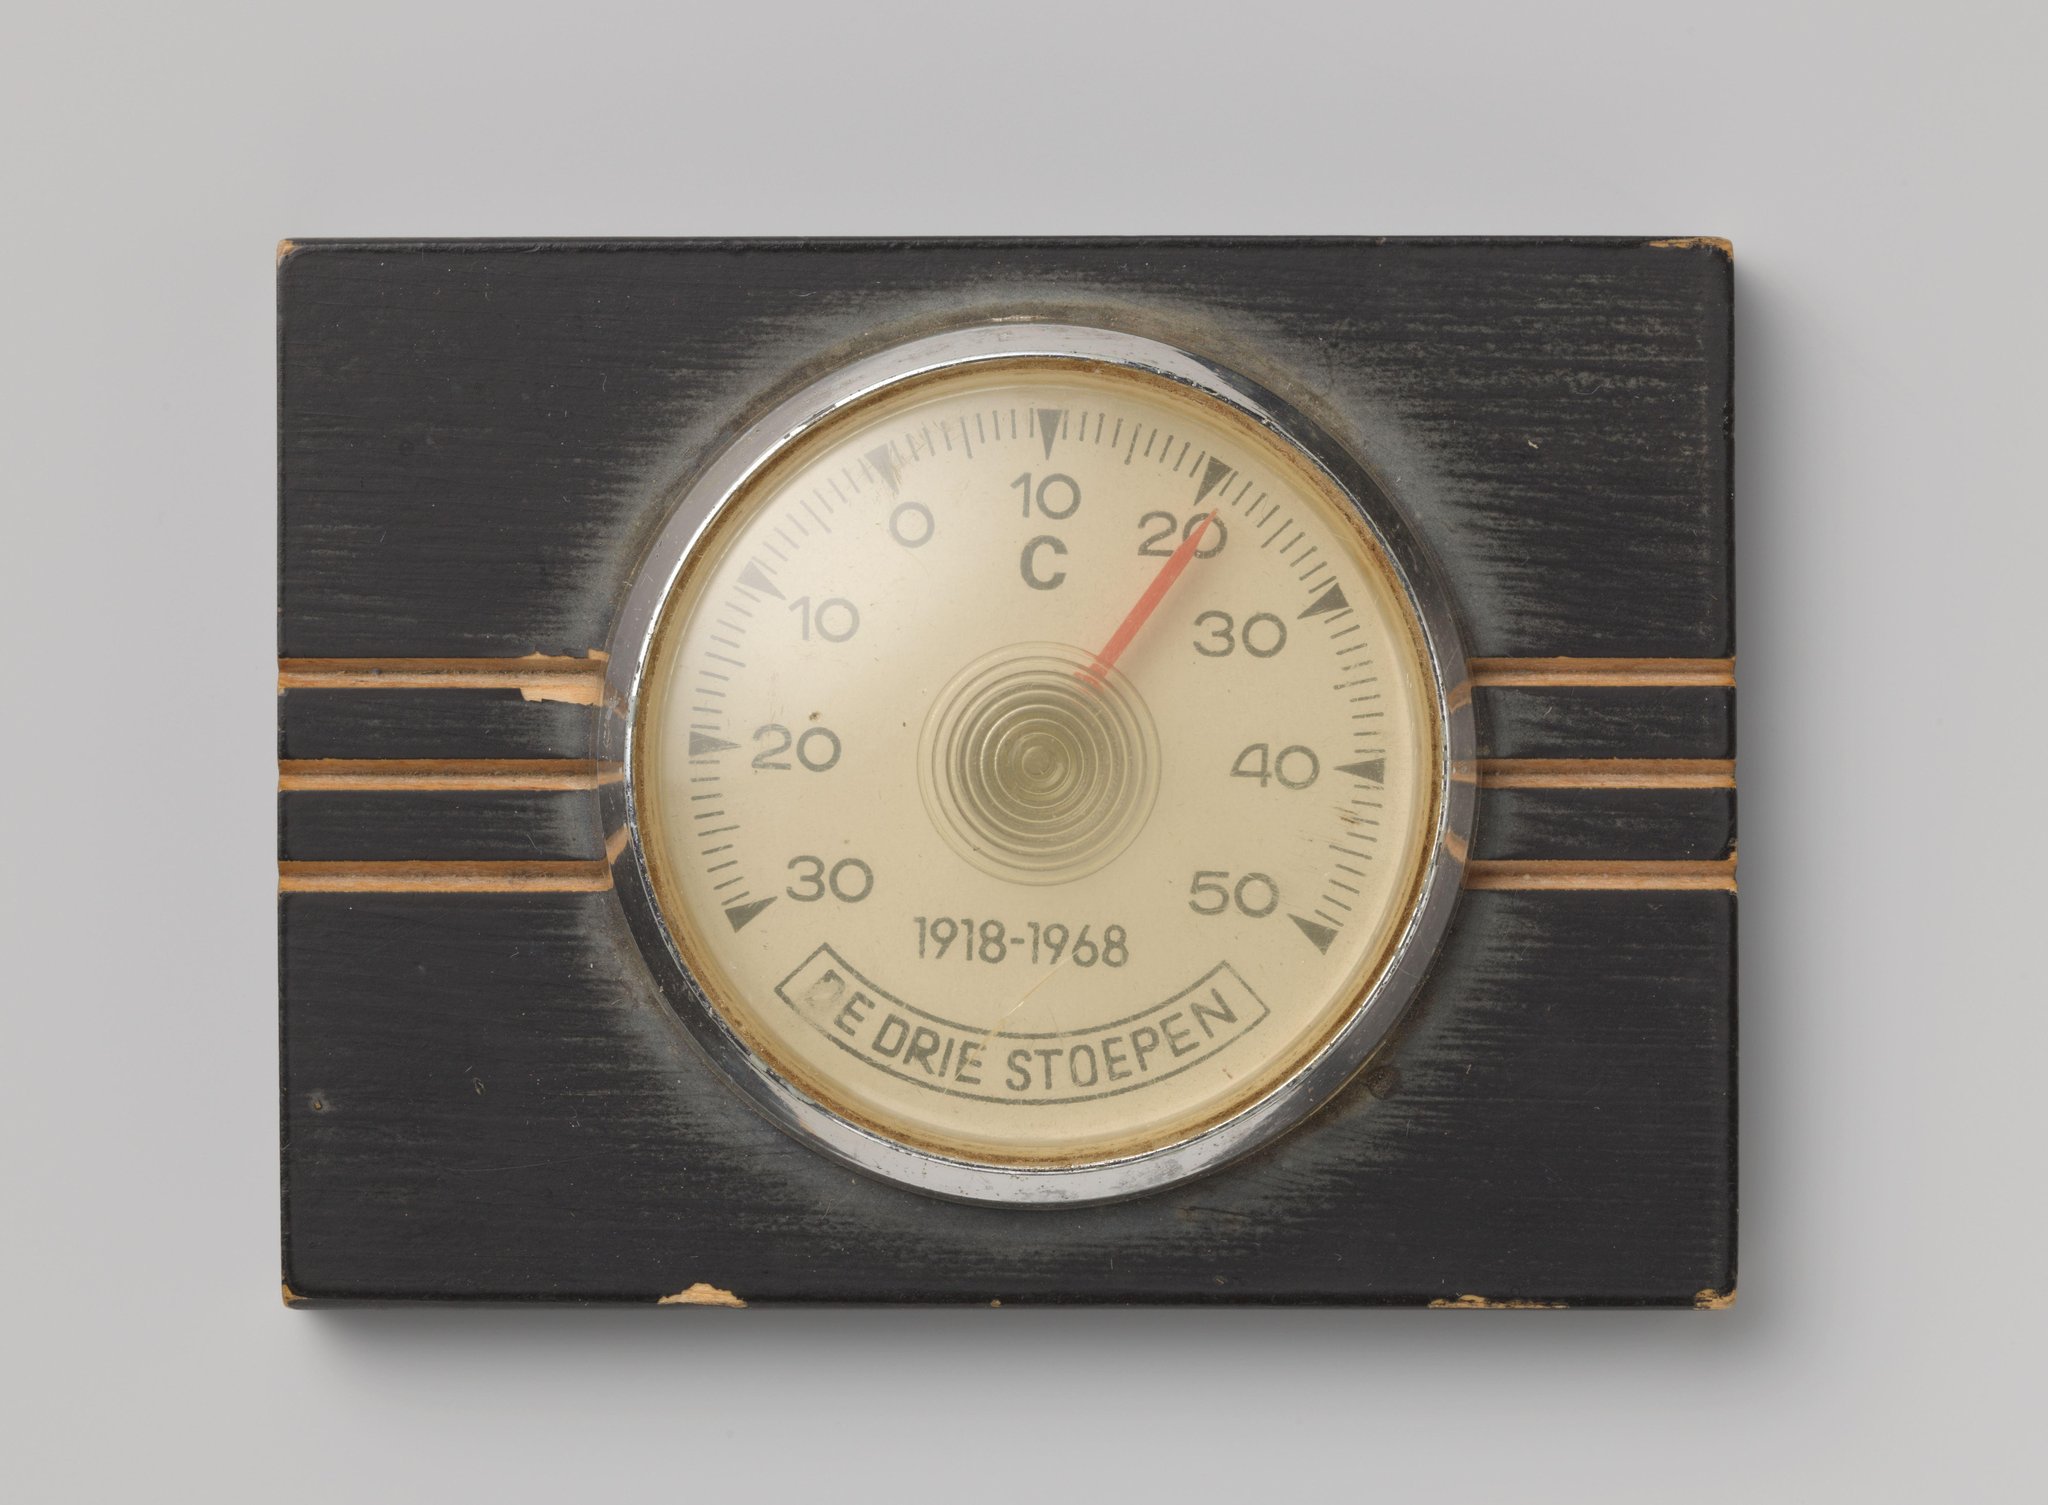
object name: thermometer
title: De drie stoepen, 1918-1968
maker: Anonymous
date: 1968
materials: metal, plastic, wood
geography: netherlands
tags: the hague, willem drees, amsterdam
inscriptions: signature and date: ‘De Drie Stoepen / 1918-1968’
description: Een wandthermometer bestaande uit een zwart houten plankje met drie horizontale strepen. Centraal op het plankje is de thermometer aangebracht. Deze geeft graden Celsius van -30 tot en met +50 aan.